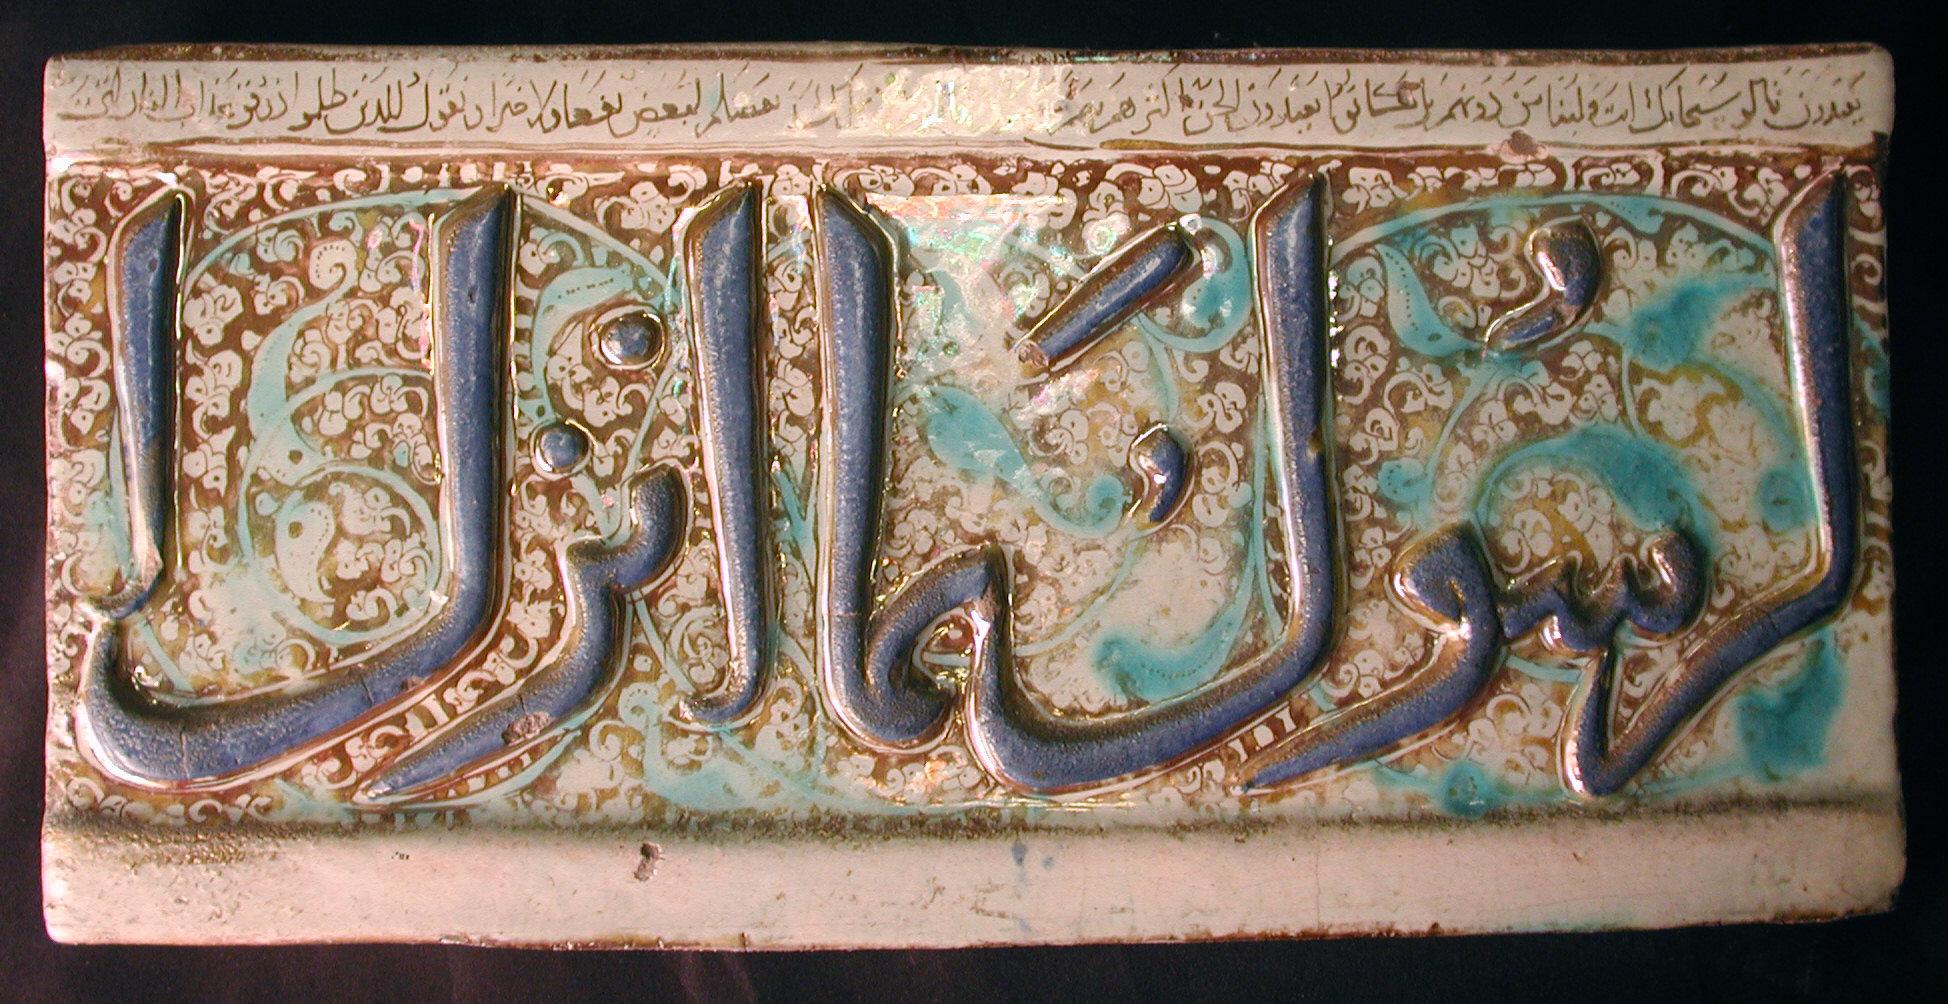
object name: tile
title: Tile from a Frieze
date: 1301-1333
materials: glaze, stonepaste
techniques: luster painting, painting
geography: iran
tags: arabic